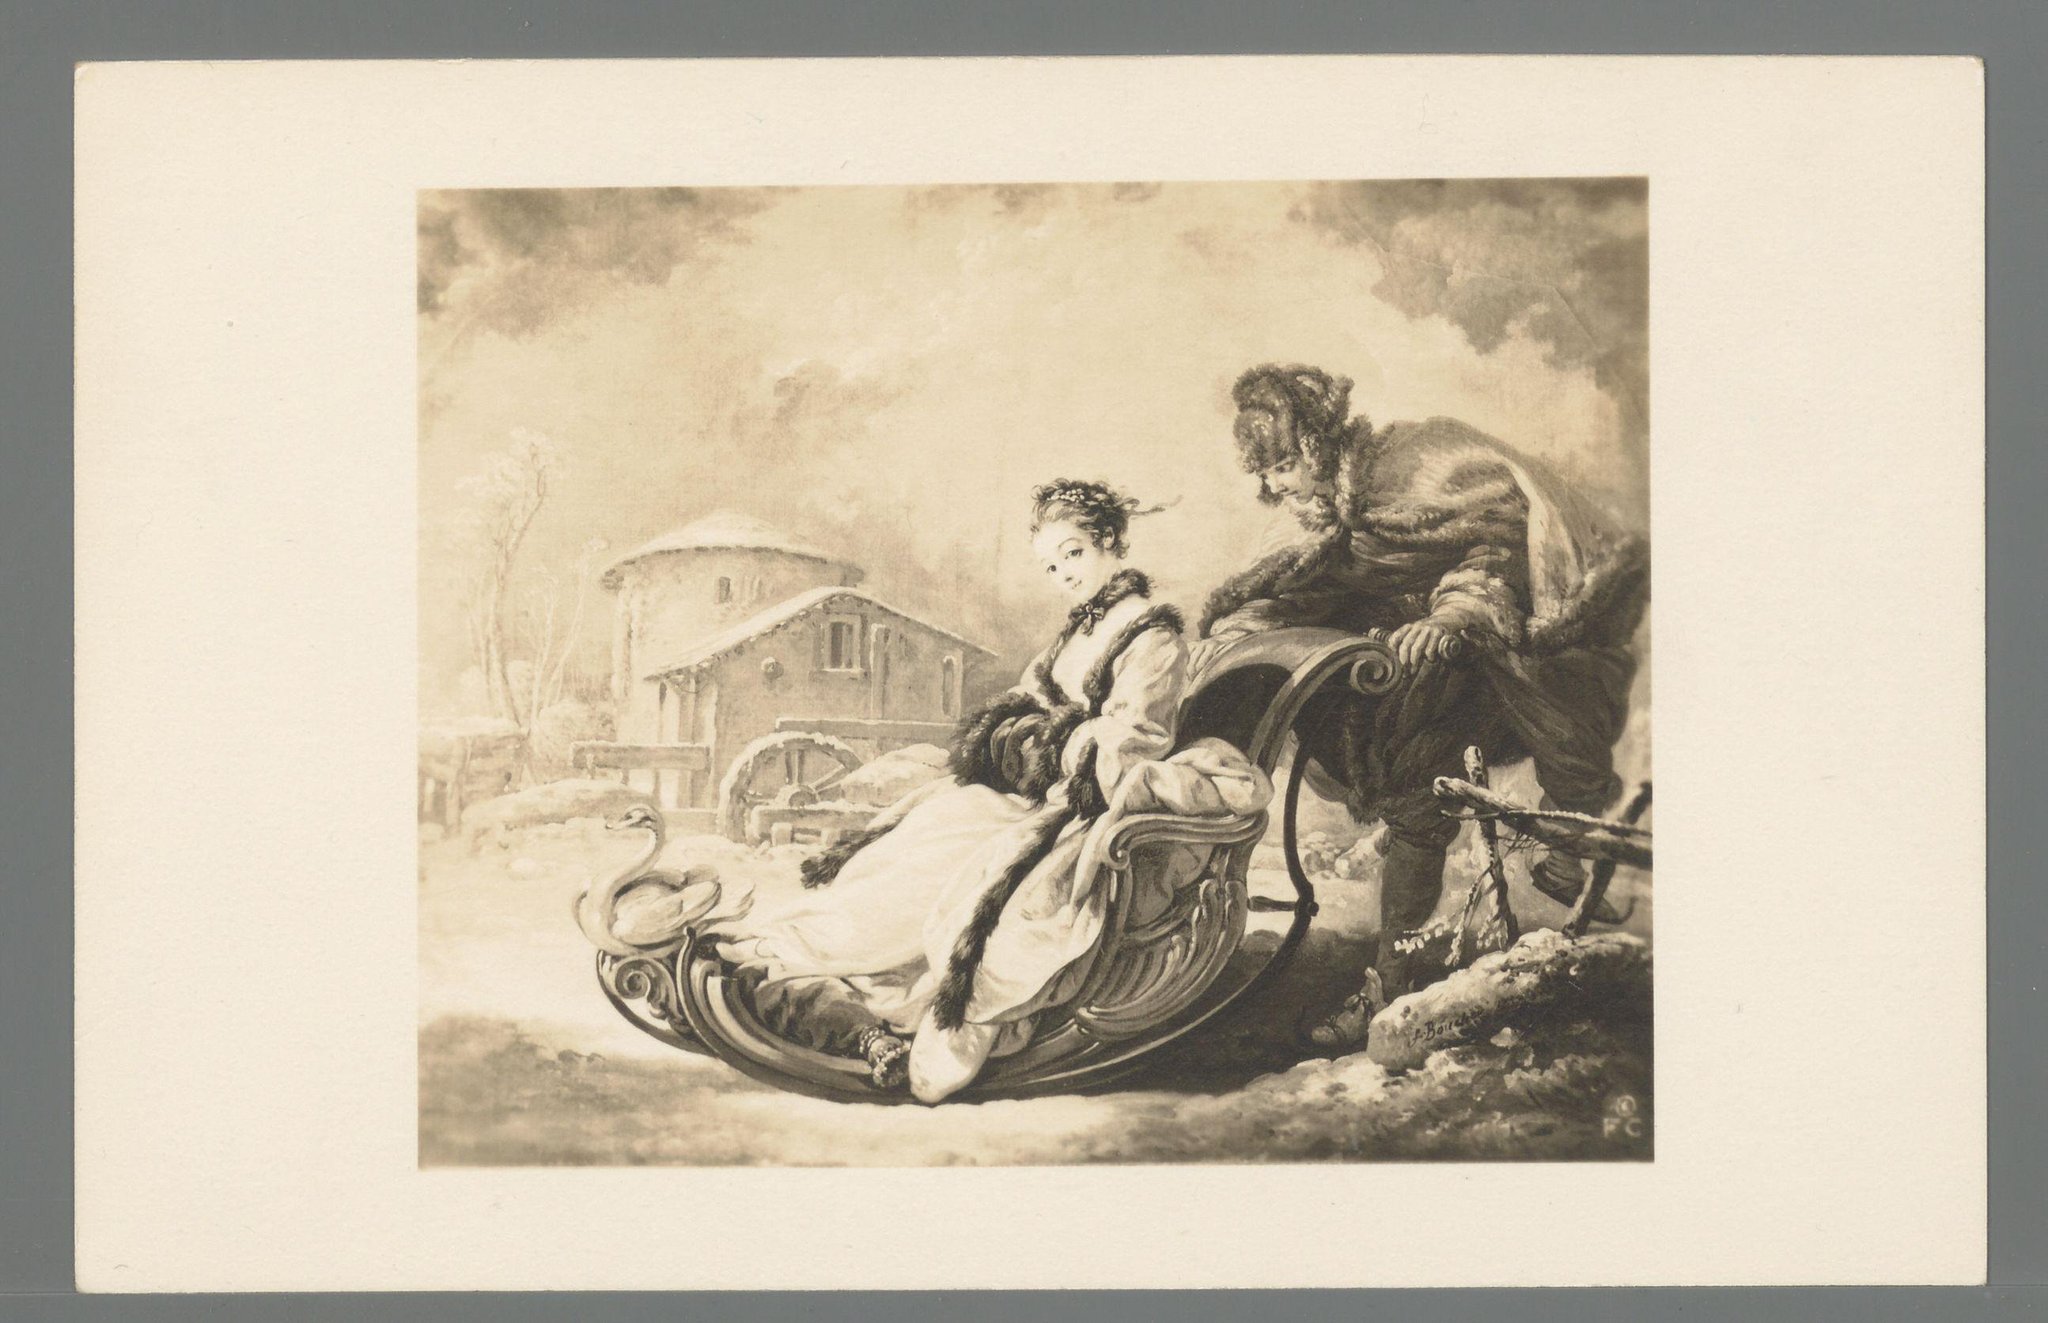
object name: ansichtkaart, prentbriefkaart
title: Winter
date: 1916-1940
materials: photographic support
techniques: photography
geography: new york city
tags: adult woman (+ one person), sleigh, sledge (non-sport), watermill